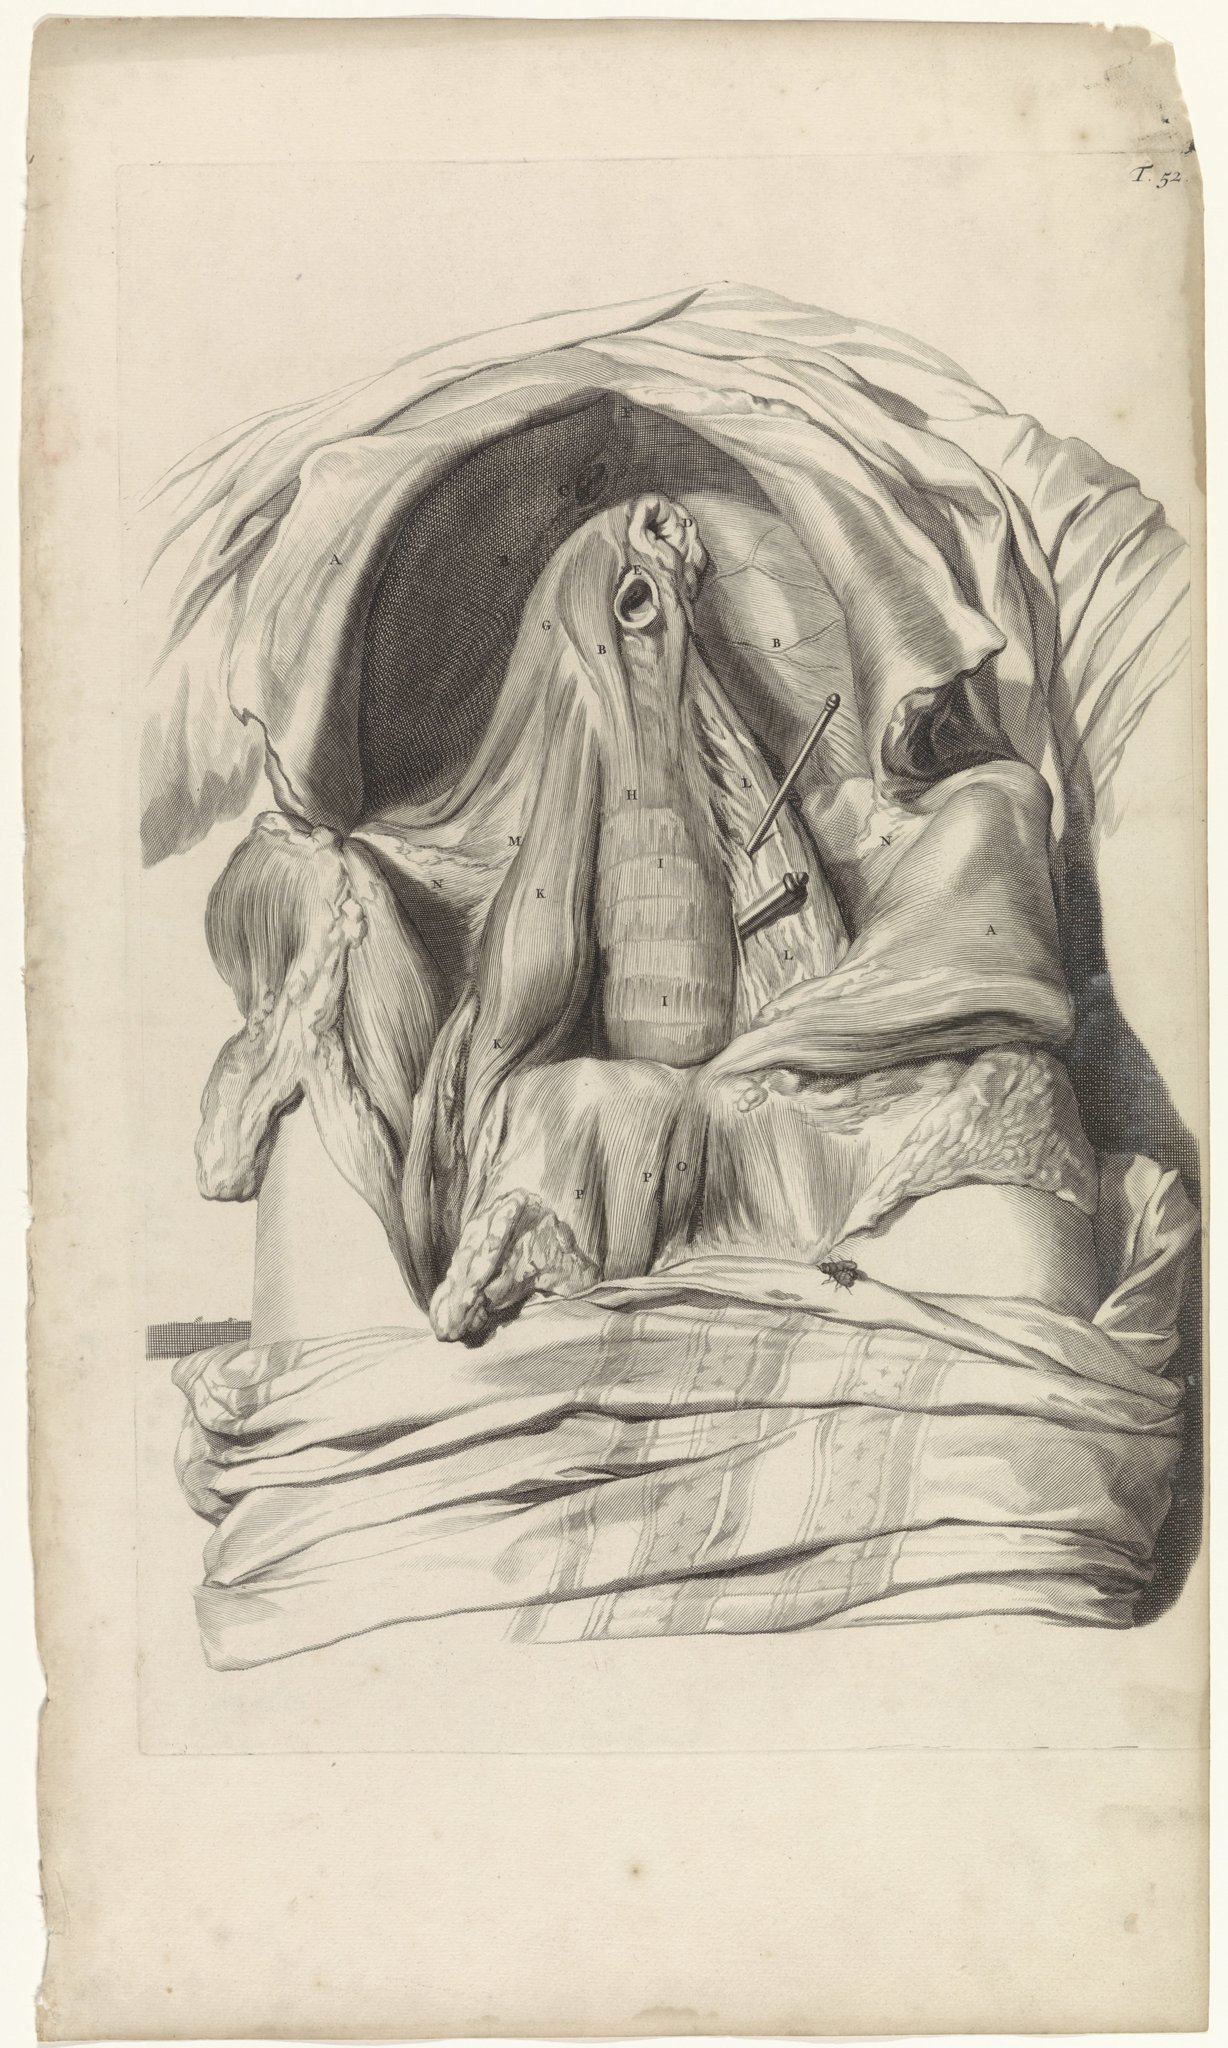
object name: print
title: Anatomische studie van de buikholte van een vrouw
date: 1685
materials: paper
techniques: engraving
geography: amsterdam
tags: abdomen, belly (human being) - aa - female human figure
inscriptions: collector's mark: Lugt 2228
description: Boekillustratie voor Bidloo, Godefridus. Anatomia humani corporis centum & quinque tabulis, per art. G. de Lairesse ad vivum delineatis, de monstrata, veterum recentiorumque inventis explicata plurimisque, hactenus non detectis, illustrata. Amsterdam: Weduwe Joannes van Someren, Hendrick Boom en erven Dirk Boom, 1685.